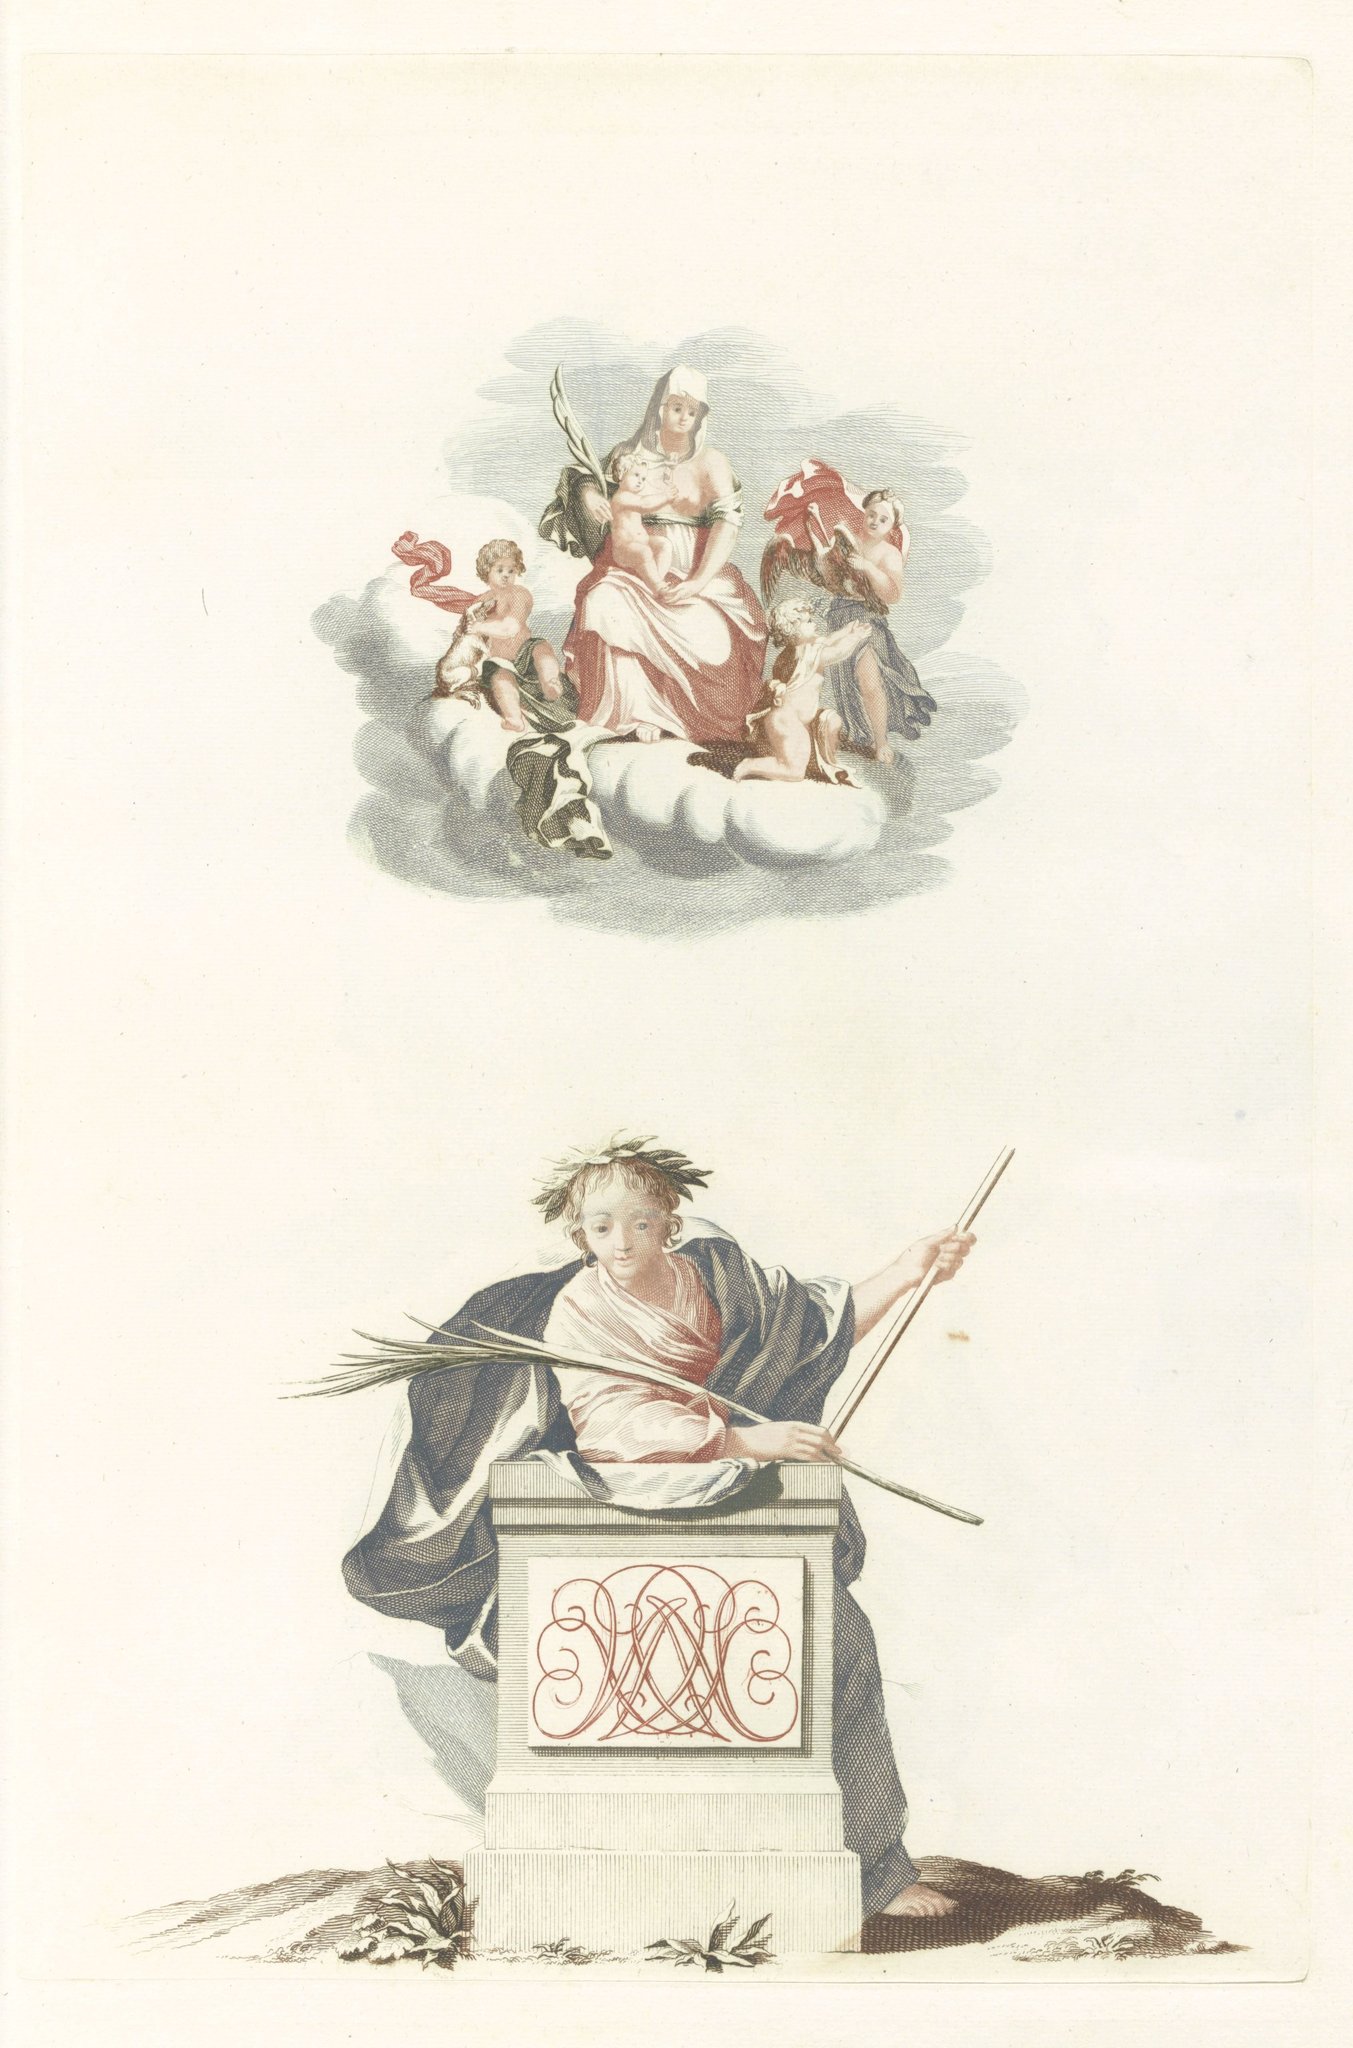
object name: print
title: Figuur leunend op een stenen pilaar met initialen en Maria op de wolken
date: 1688-1698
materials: paper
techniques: engraving, etching, lithography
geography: netherlands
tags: madonna: i.e. mary with the christ-child, leaning figure, dog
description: Op de wolken zit een vrouw met een kind op schoot en een palmtak in de hand. Wellicht Maria met Christuskind. Naast haar een jongen met een hond, een staande jongen met vogel in de armen en een geknielde jongen. Onder een gelauwerde figuur met palmtak leunend op een stenen monument met initialen. Deze prent maakt deel uit van een album.